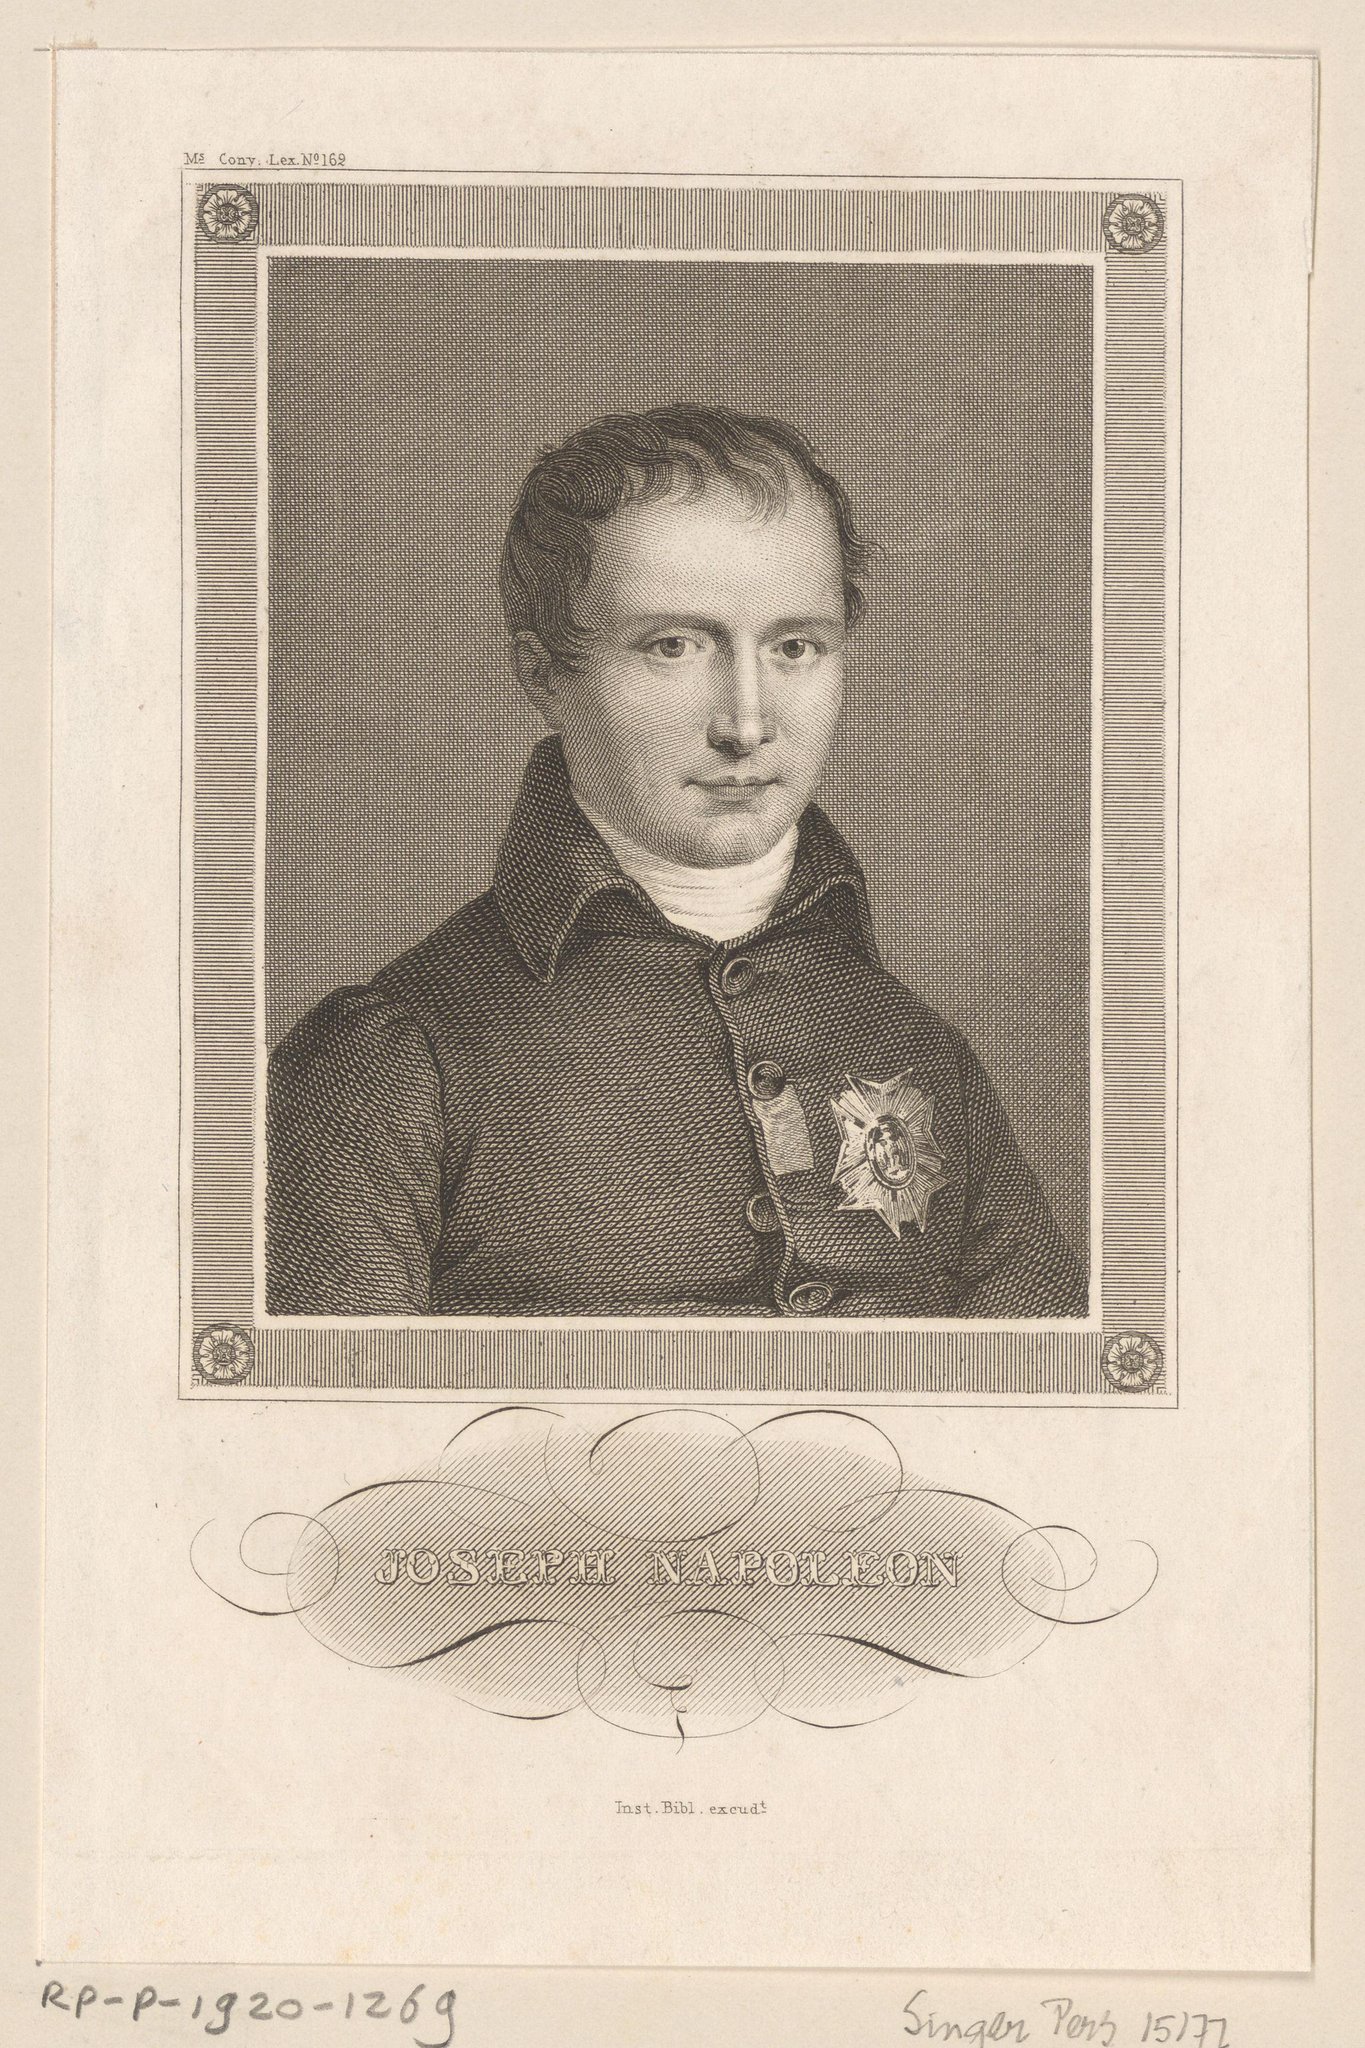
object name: print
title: Portret van Jozef Bonaparte, koning van Spanje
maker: Anonymous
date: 1840-1855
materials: paper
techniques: engraving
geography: hildburghausen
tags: knighthood order, historical persons, king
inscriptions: collector's mark: Lugt 2228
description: Prent mogelijk uit: Meyer, Joseph. Das Grosse Conversations-Lexikon für die gebildeten Stände. Hildburghausen: Bibliographisches Institut, 1840-1855.